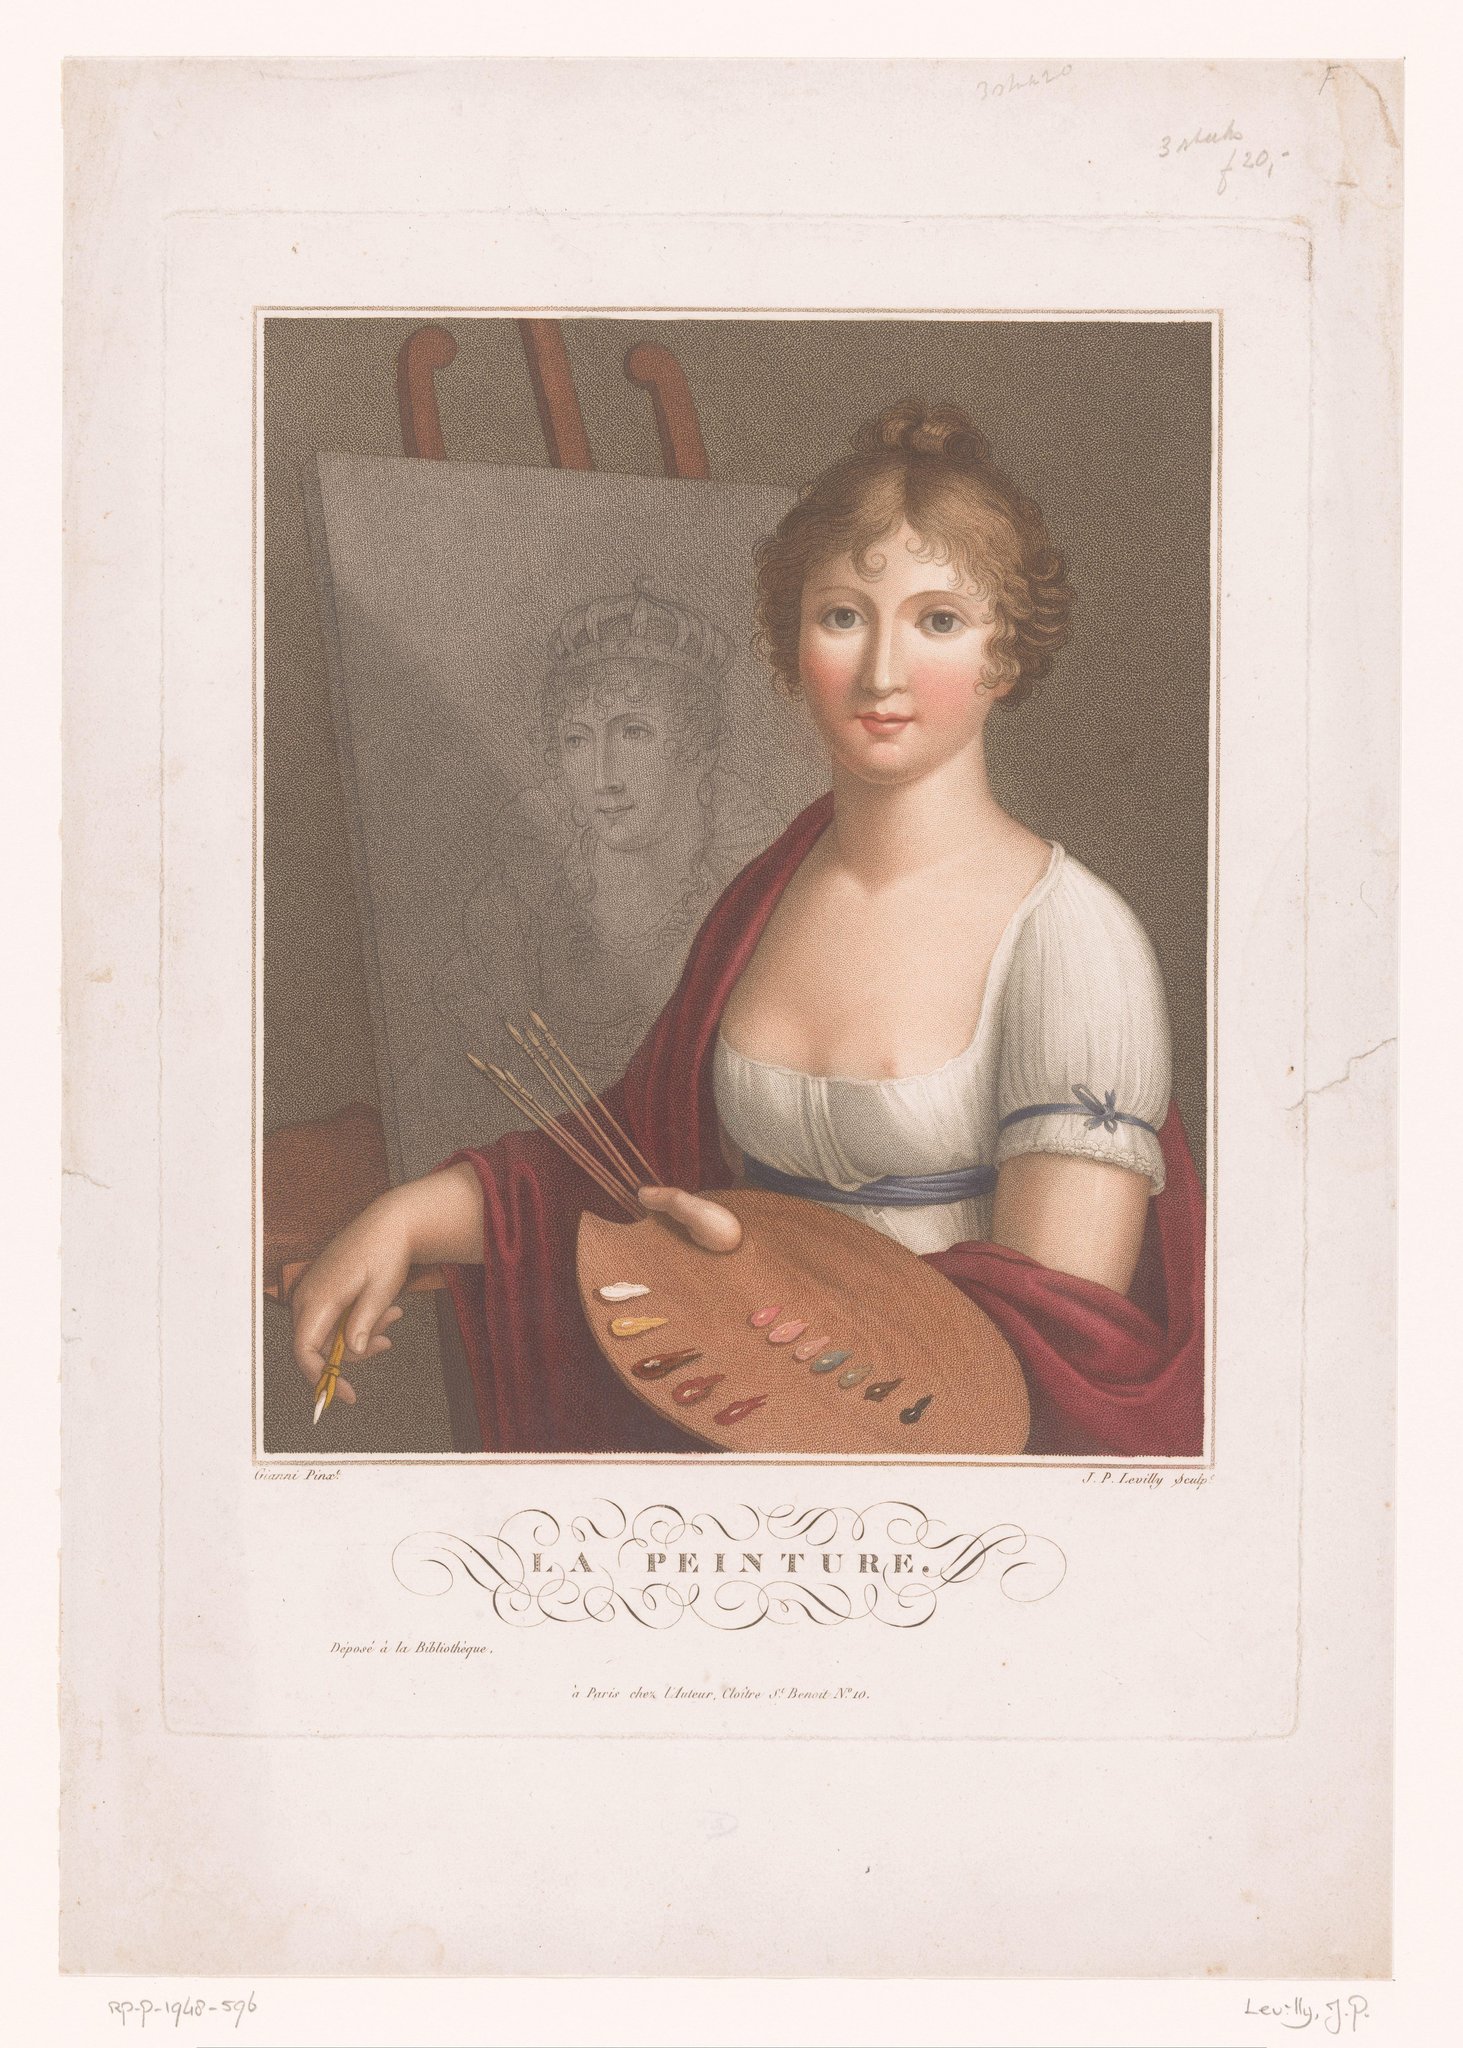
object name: print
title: La Peinture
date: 1780-1800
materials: paper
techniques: engraving, lithography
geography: paris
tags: 'pictura', symbolic representations, allegories and emblems ~ painting; 'pittura' (ripa), tools, implements of painter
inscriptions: collector's mark: Lugt 2228, : ‘Déposé à la Bibliothèque.’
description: Maakt deel uit van een vierdelige serie met personificaties van de Kunsten.